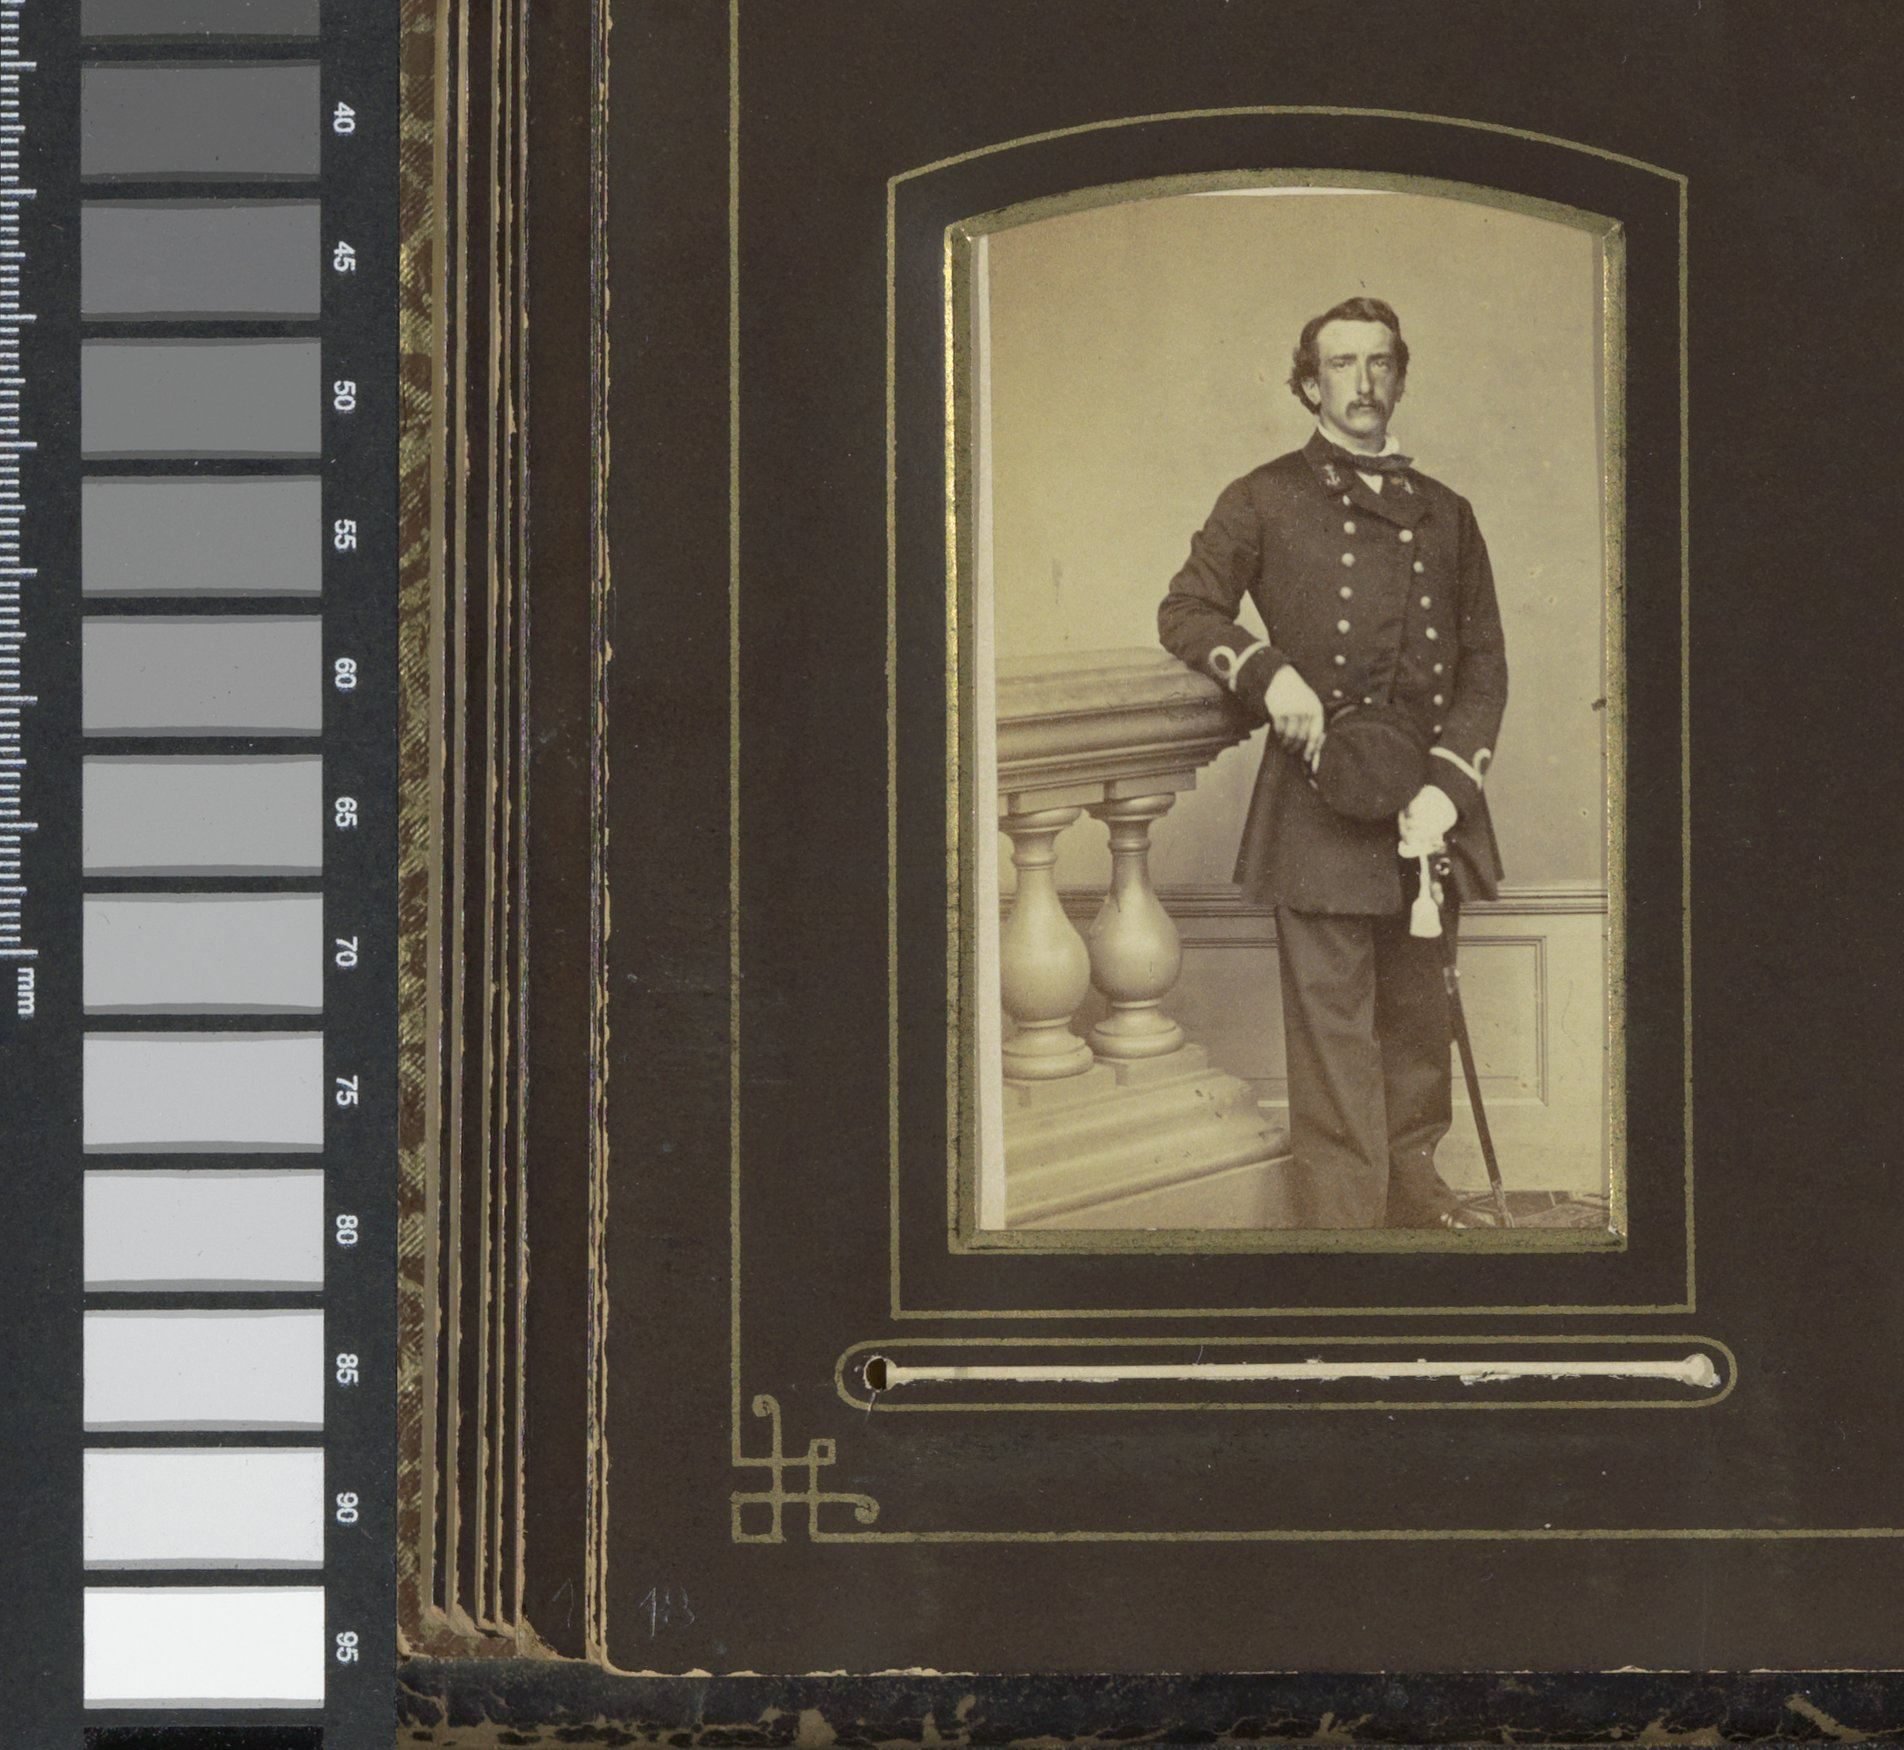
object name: album leaf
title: Portret van een man in een militair uniform, staand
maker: gerrit hoogwinkel jr.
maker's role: fotograaf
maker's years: 1837-1890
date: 1860-1870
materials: cardboard, paper, photographic support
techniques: albumen print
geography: rotterdam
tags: studio requisites ~ photographer, adult man, (military) uniforms, historical persons not known by name, rotterdam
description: Onderdeel van Fotoalbum van de families Matthes, Doorman en Van Thiel.